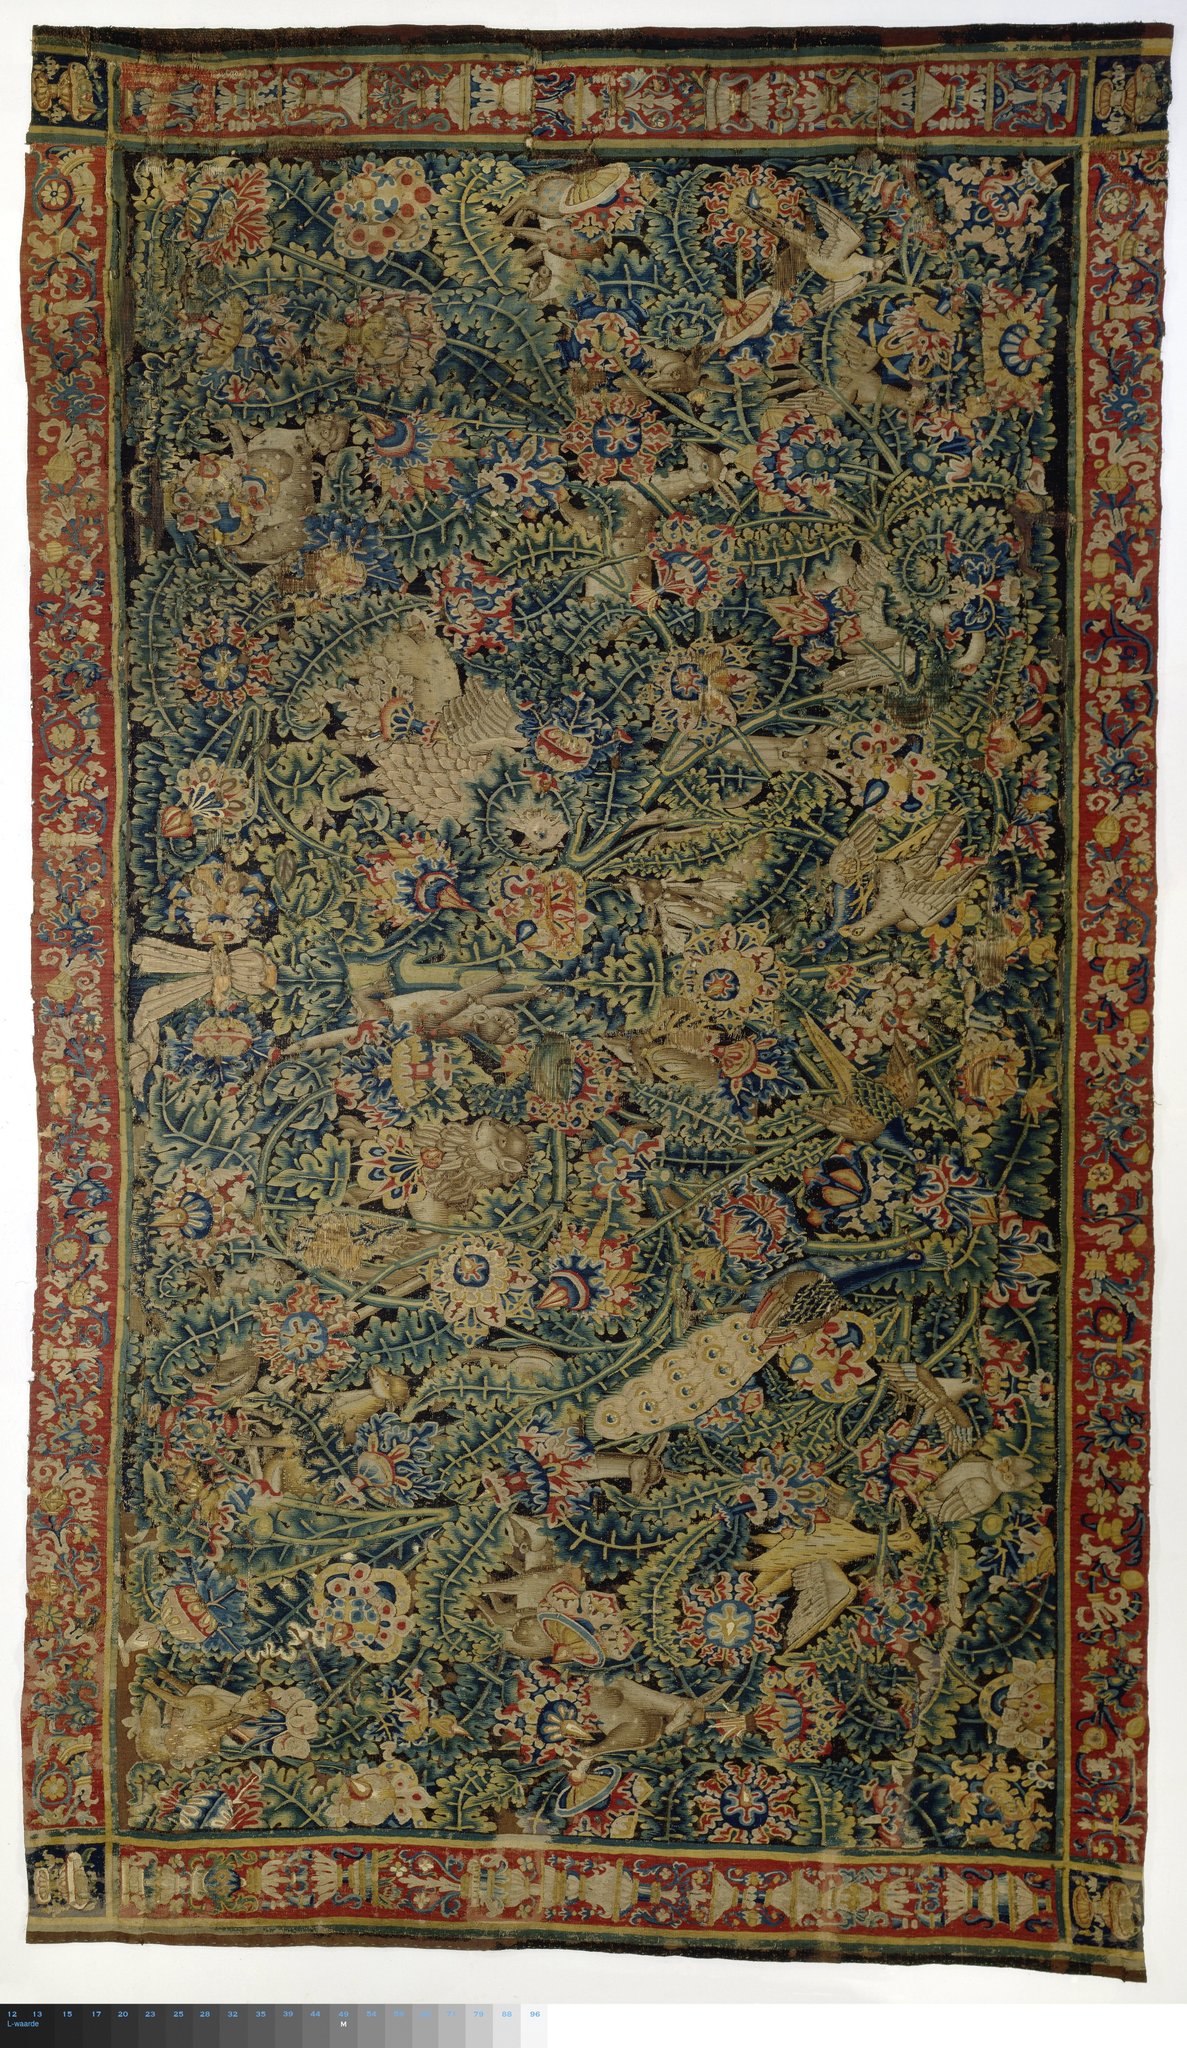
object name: tapestry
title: Grootbladige verdure met dieren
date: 1525-1530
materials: silk, wool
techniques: tapestry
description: Tapestry. Giant-leaf verdure with flowers, leaves and animals. Wool. Southern Netherlands (Tournai ?), c. 1525.